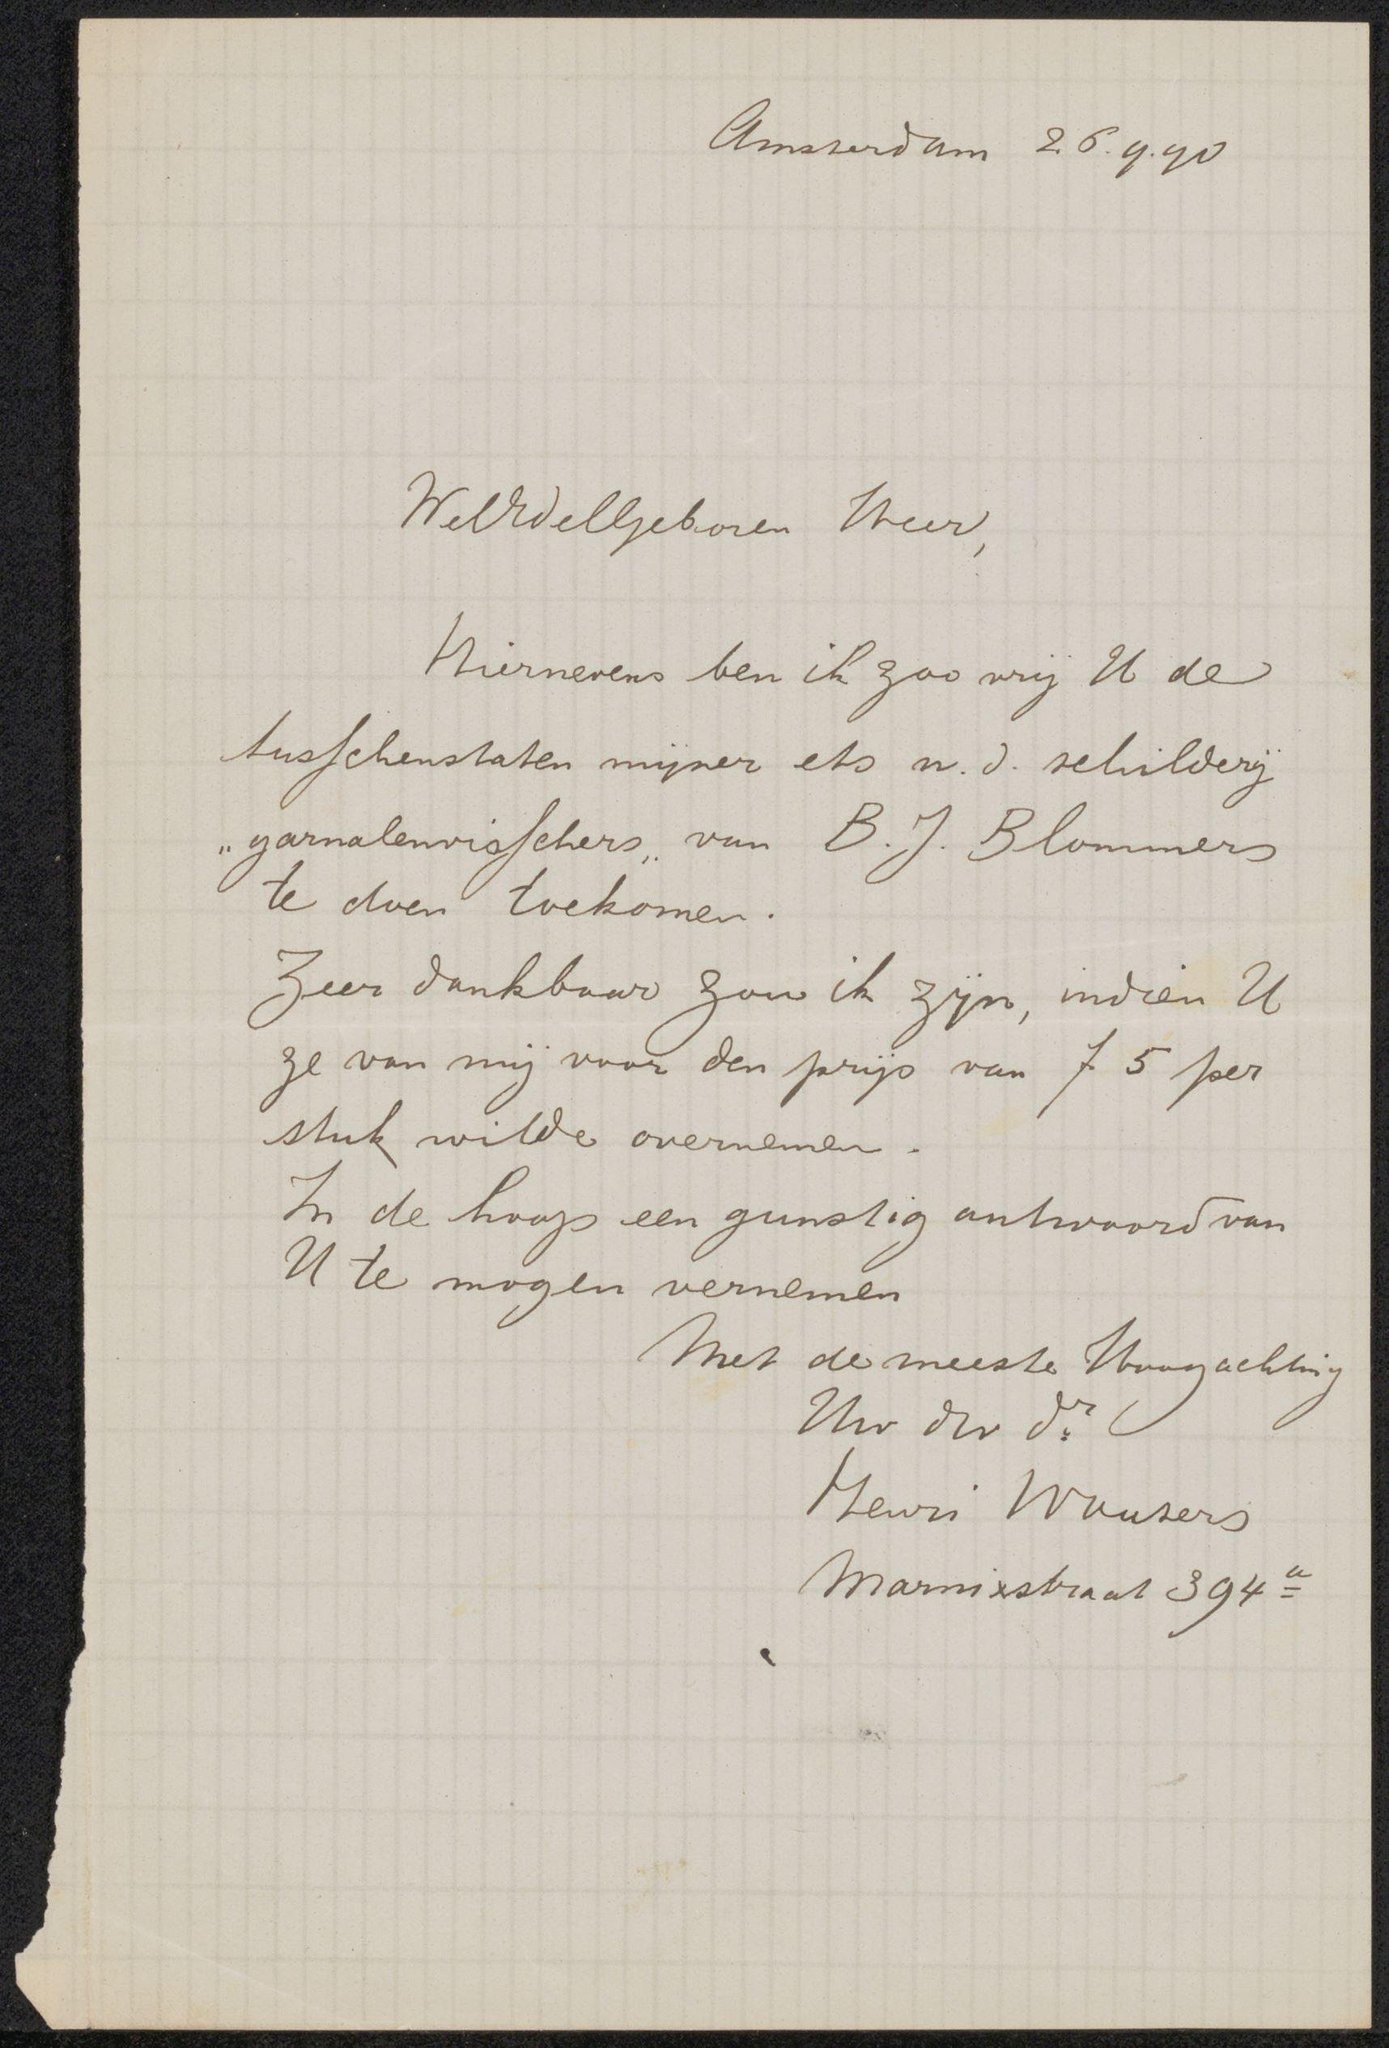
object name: letter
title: Brief aan Johan Philip van der Kellen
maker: henri wouters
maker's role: draughtsman, print maker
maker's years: 1866-1935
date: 1890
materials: ink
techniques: pen, writing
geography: amsterdam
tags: the hague, bernardus johannes blommers, utrecht, print maker, draughtsman, johan philip van der kellen, the graphic arts, art collecting, money